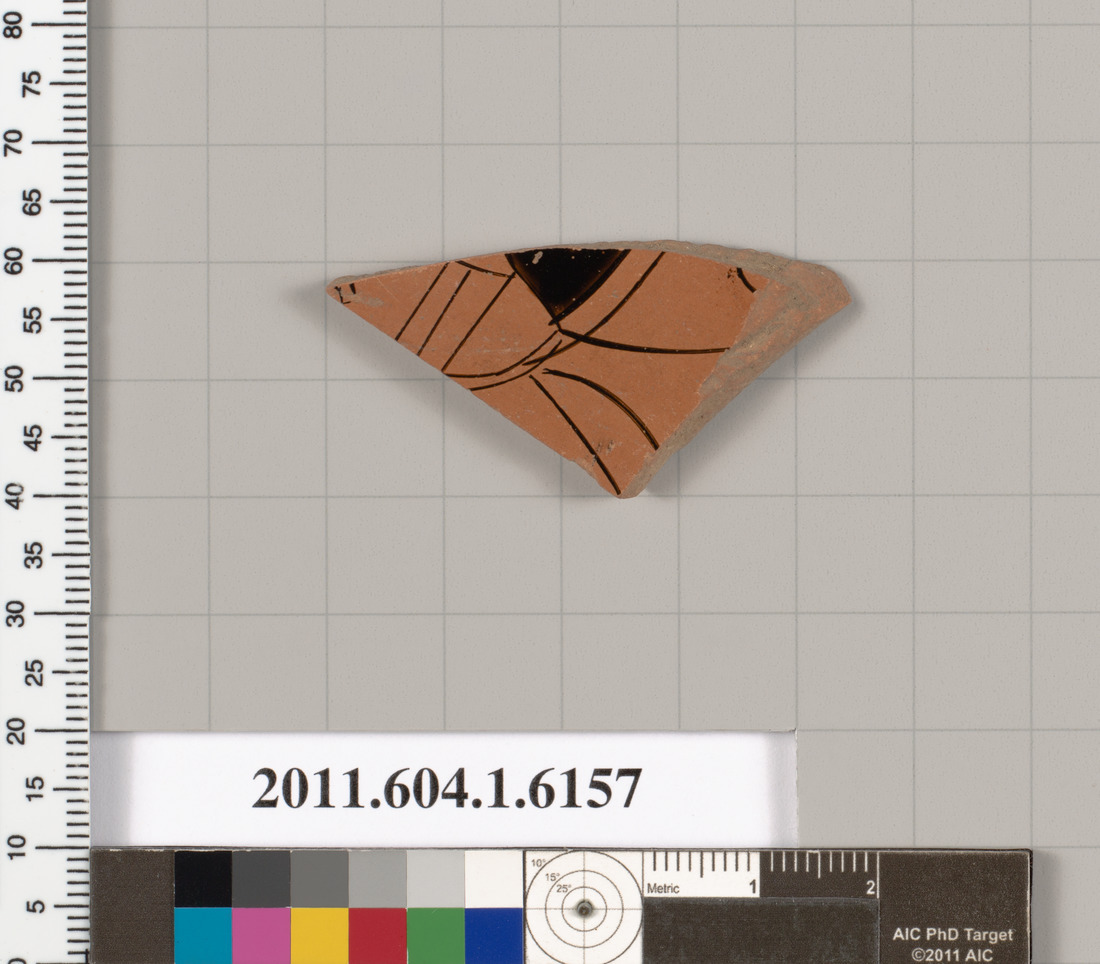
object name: kylix fragment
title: Terracotta fragment of a kylix (drinking cup)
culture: greek, attic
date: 520-500 BCE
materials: terracotta